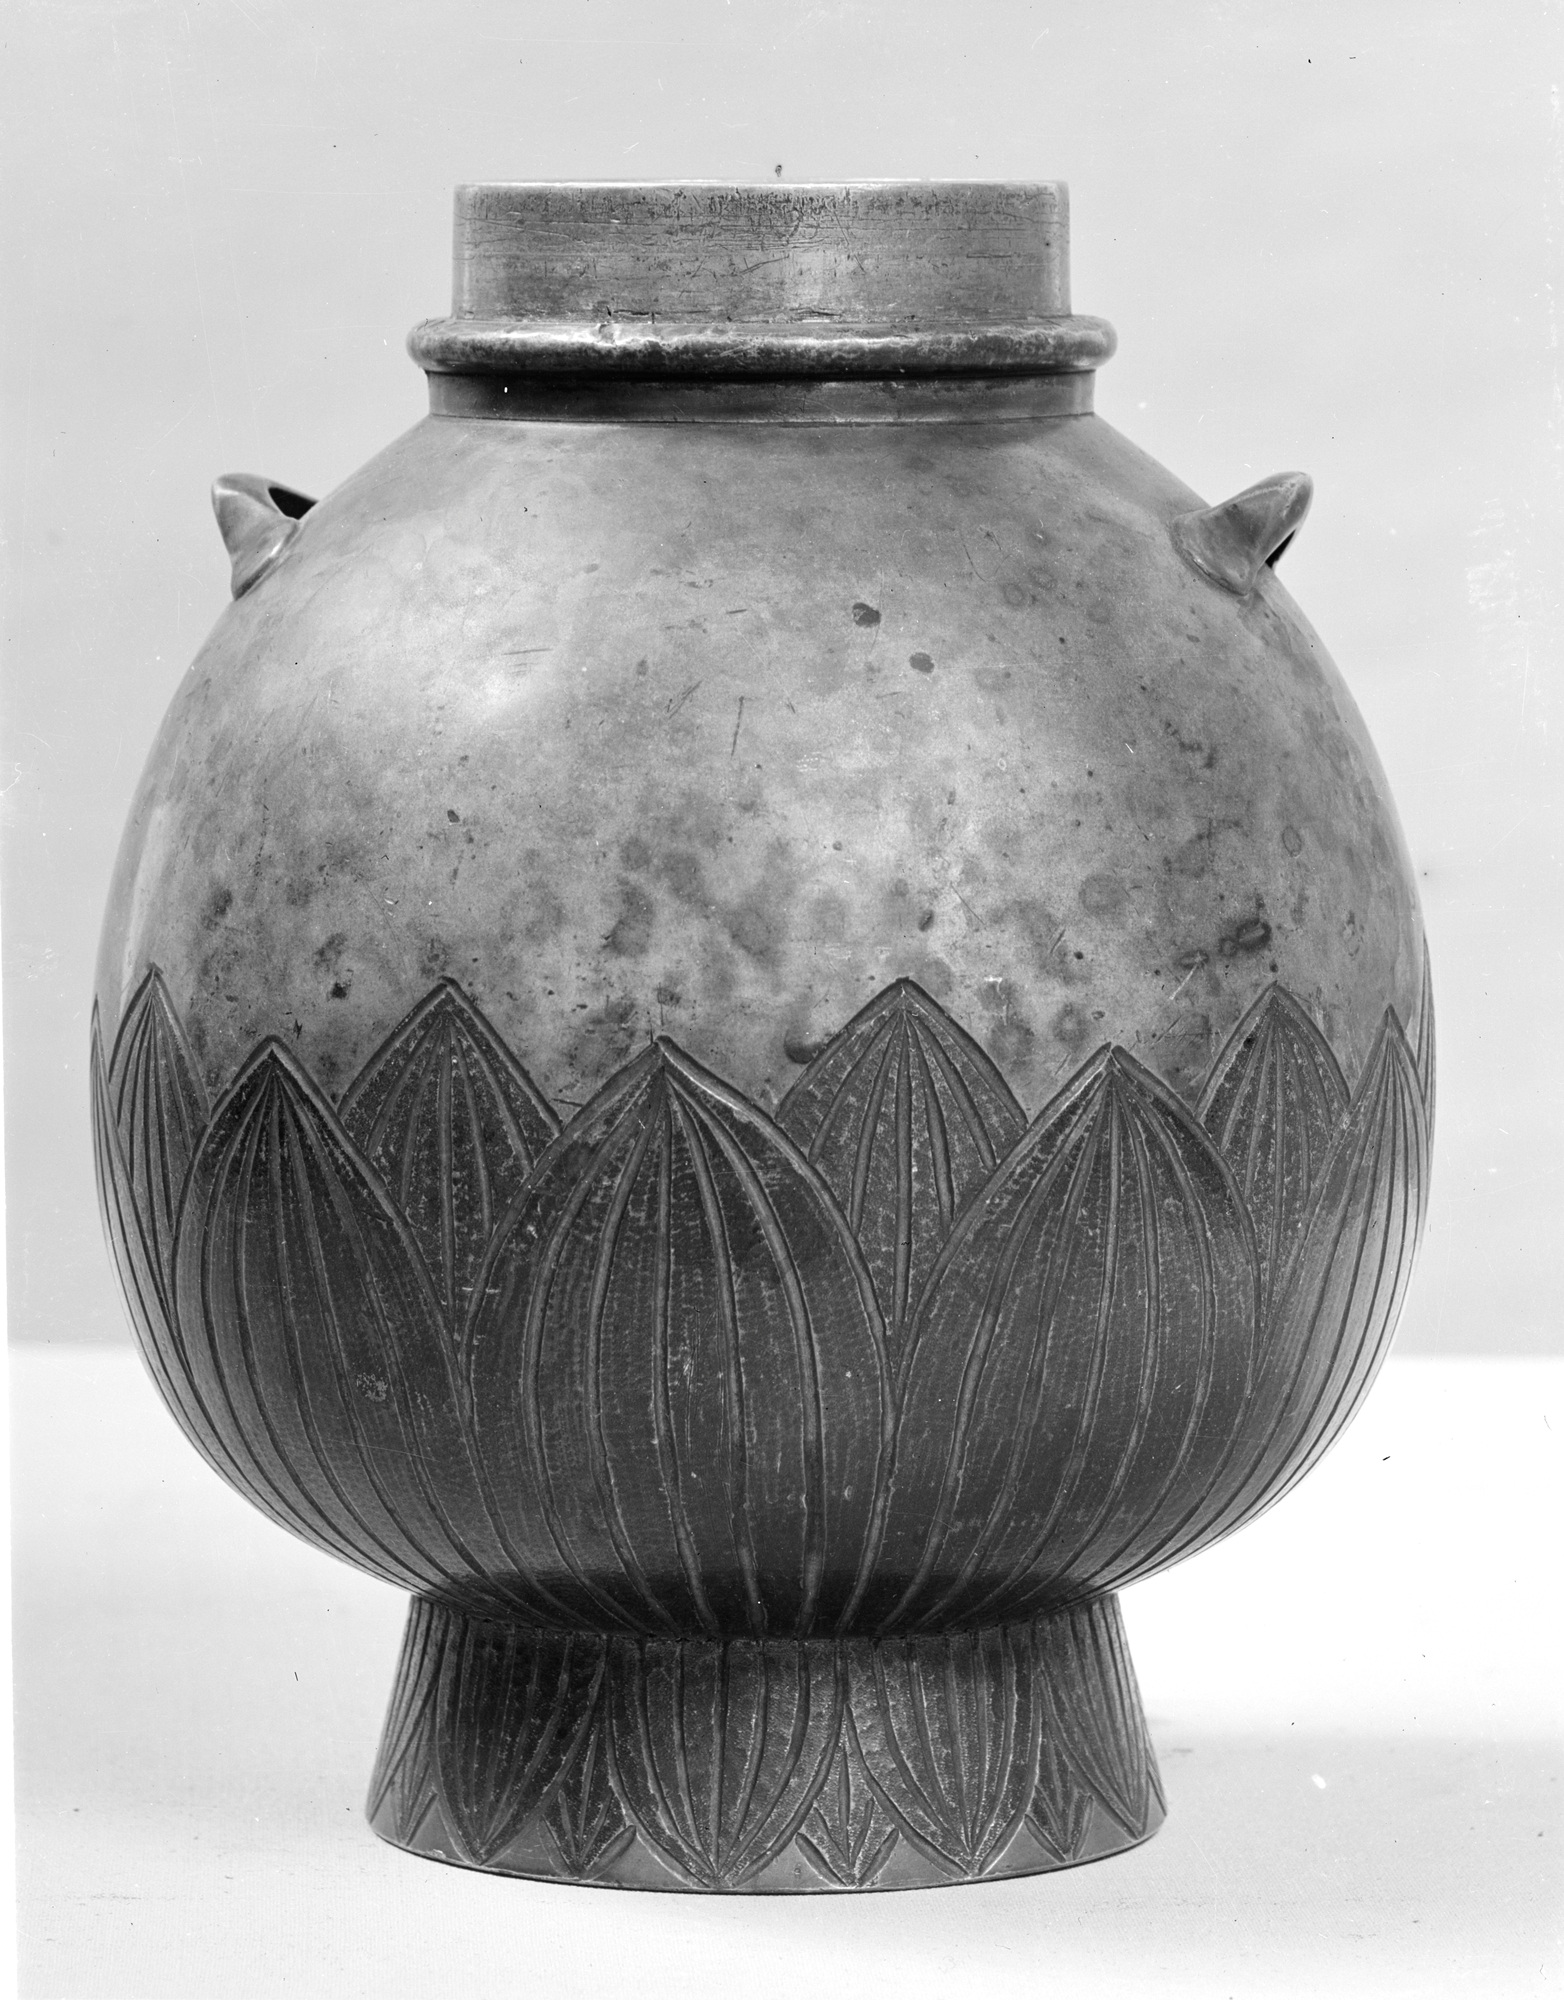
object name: jar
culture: japanese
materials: pewter